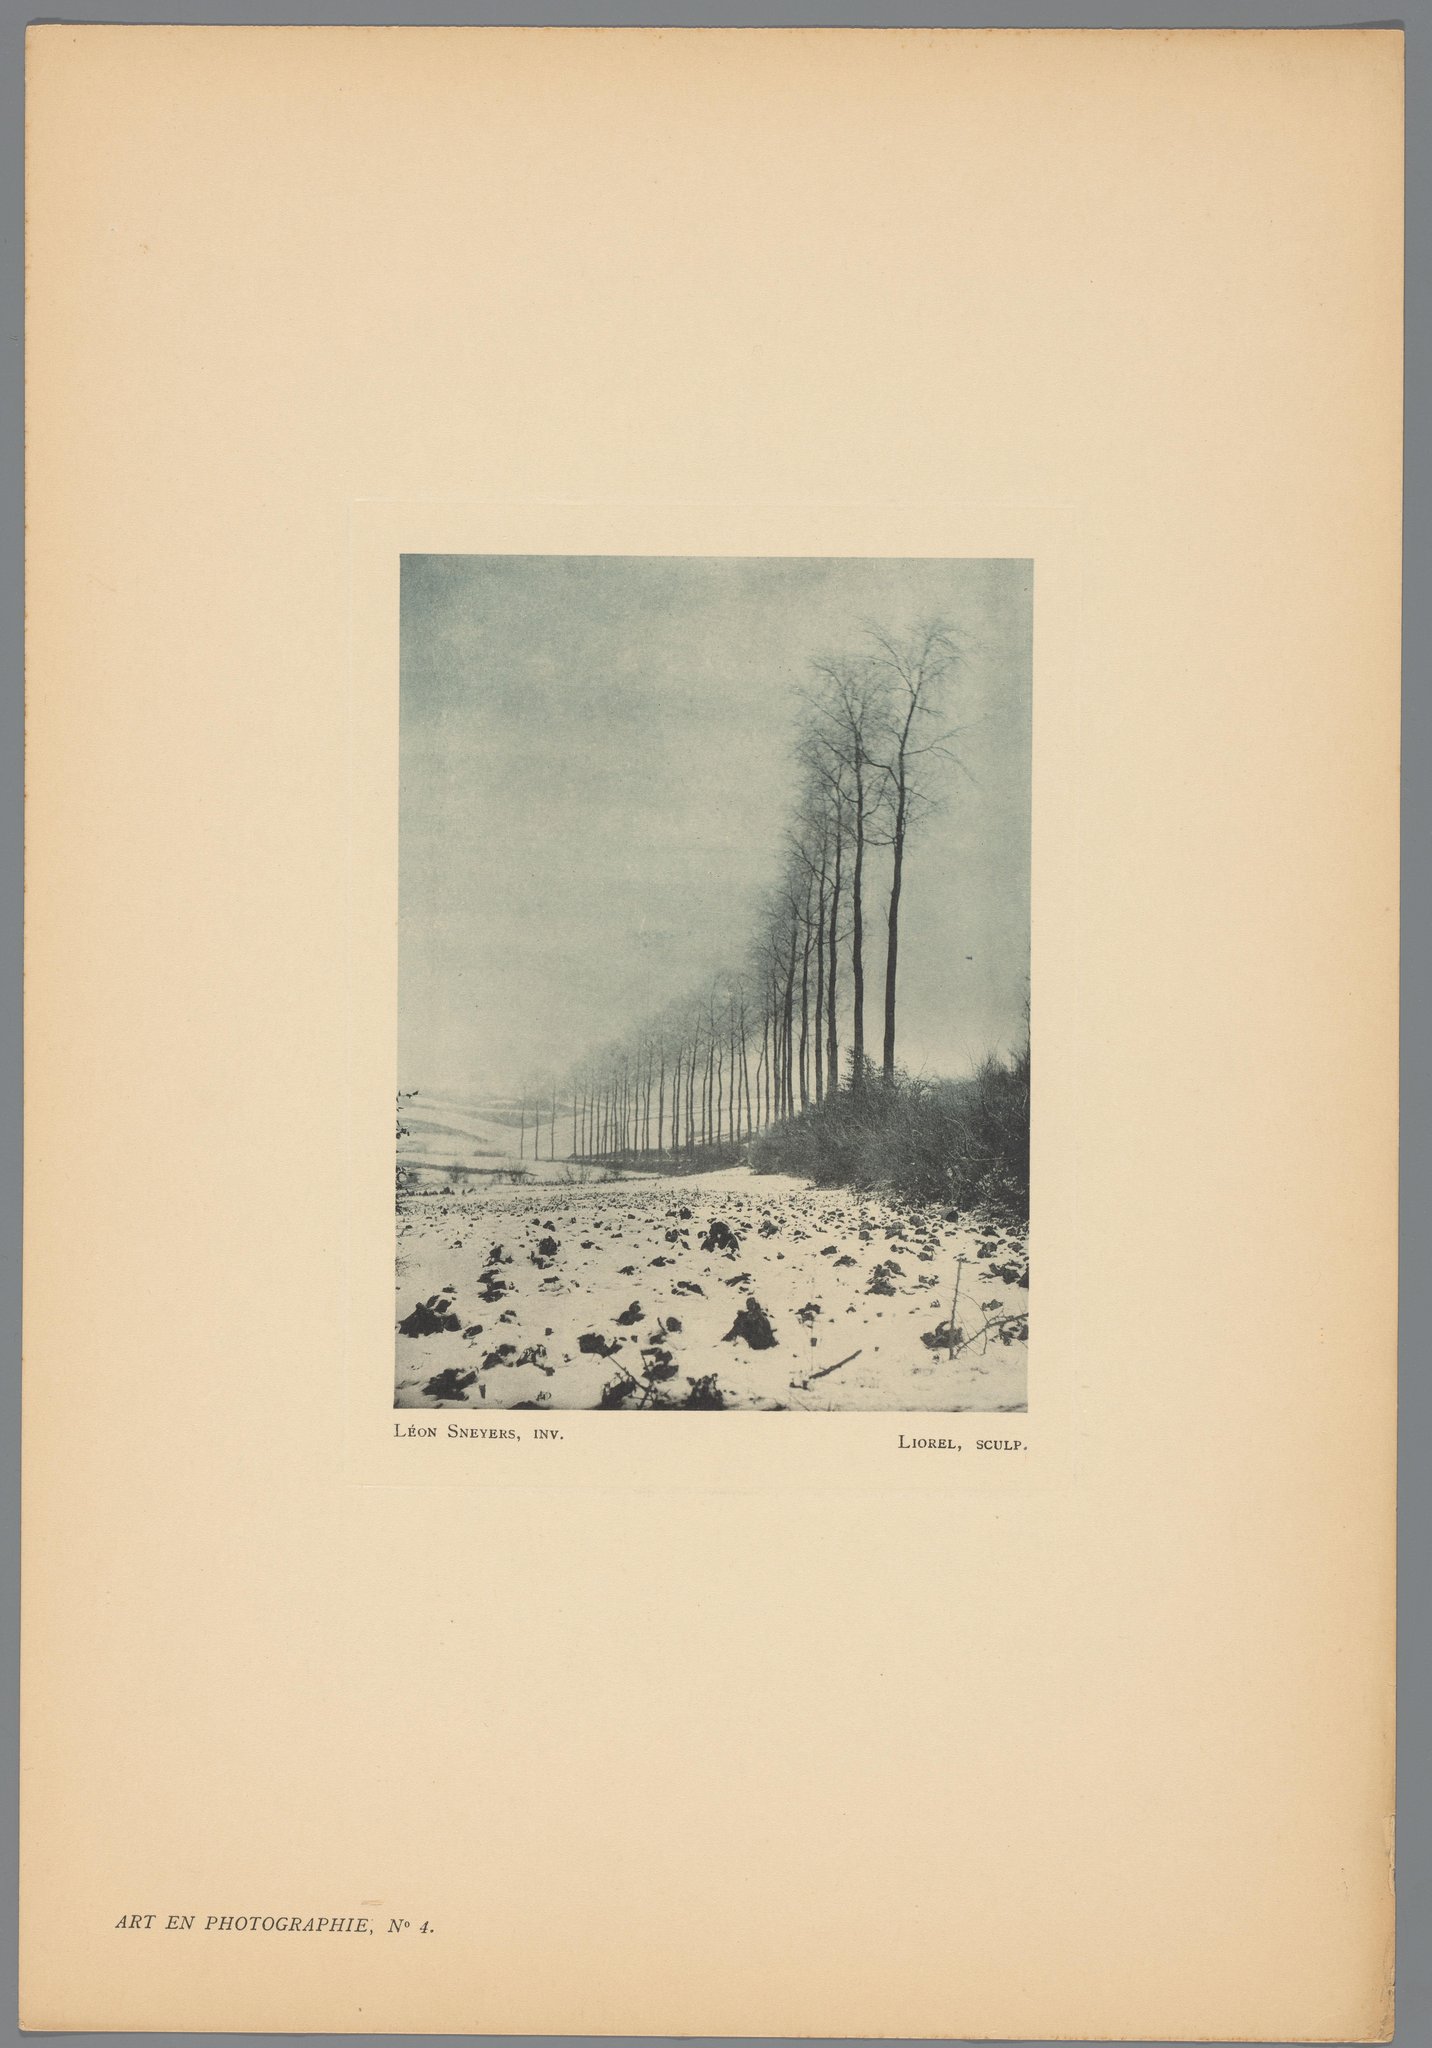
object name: photomechanical print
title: Winterlandschap met bomenrij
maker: léon sneyers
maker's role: architect, fotograaf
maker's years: 1877-1949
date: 1896-1901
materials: paper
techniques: photograph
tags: trees, winter landscape; landscape symbolizing winter (the four seasons of the year)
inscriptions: inscription: ‘ART EN PHOTOGRAPHIE, No 4.’, number: ‘NB 286’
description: Deze prent maakt deel uit van een omslag met 54 prenten op 52 bladen.